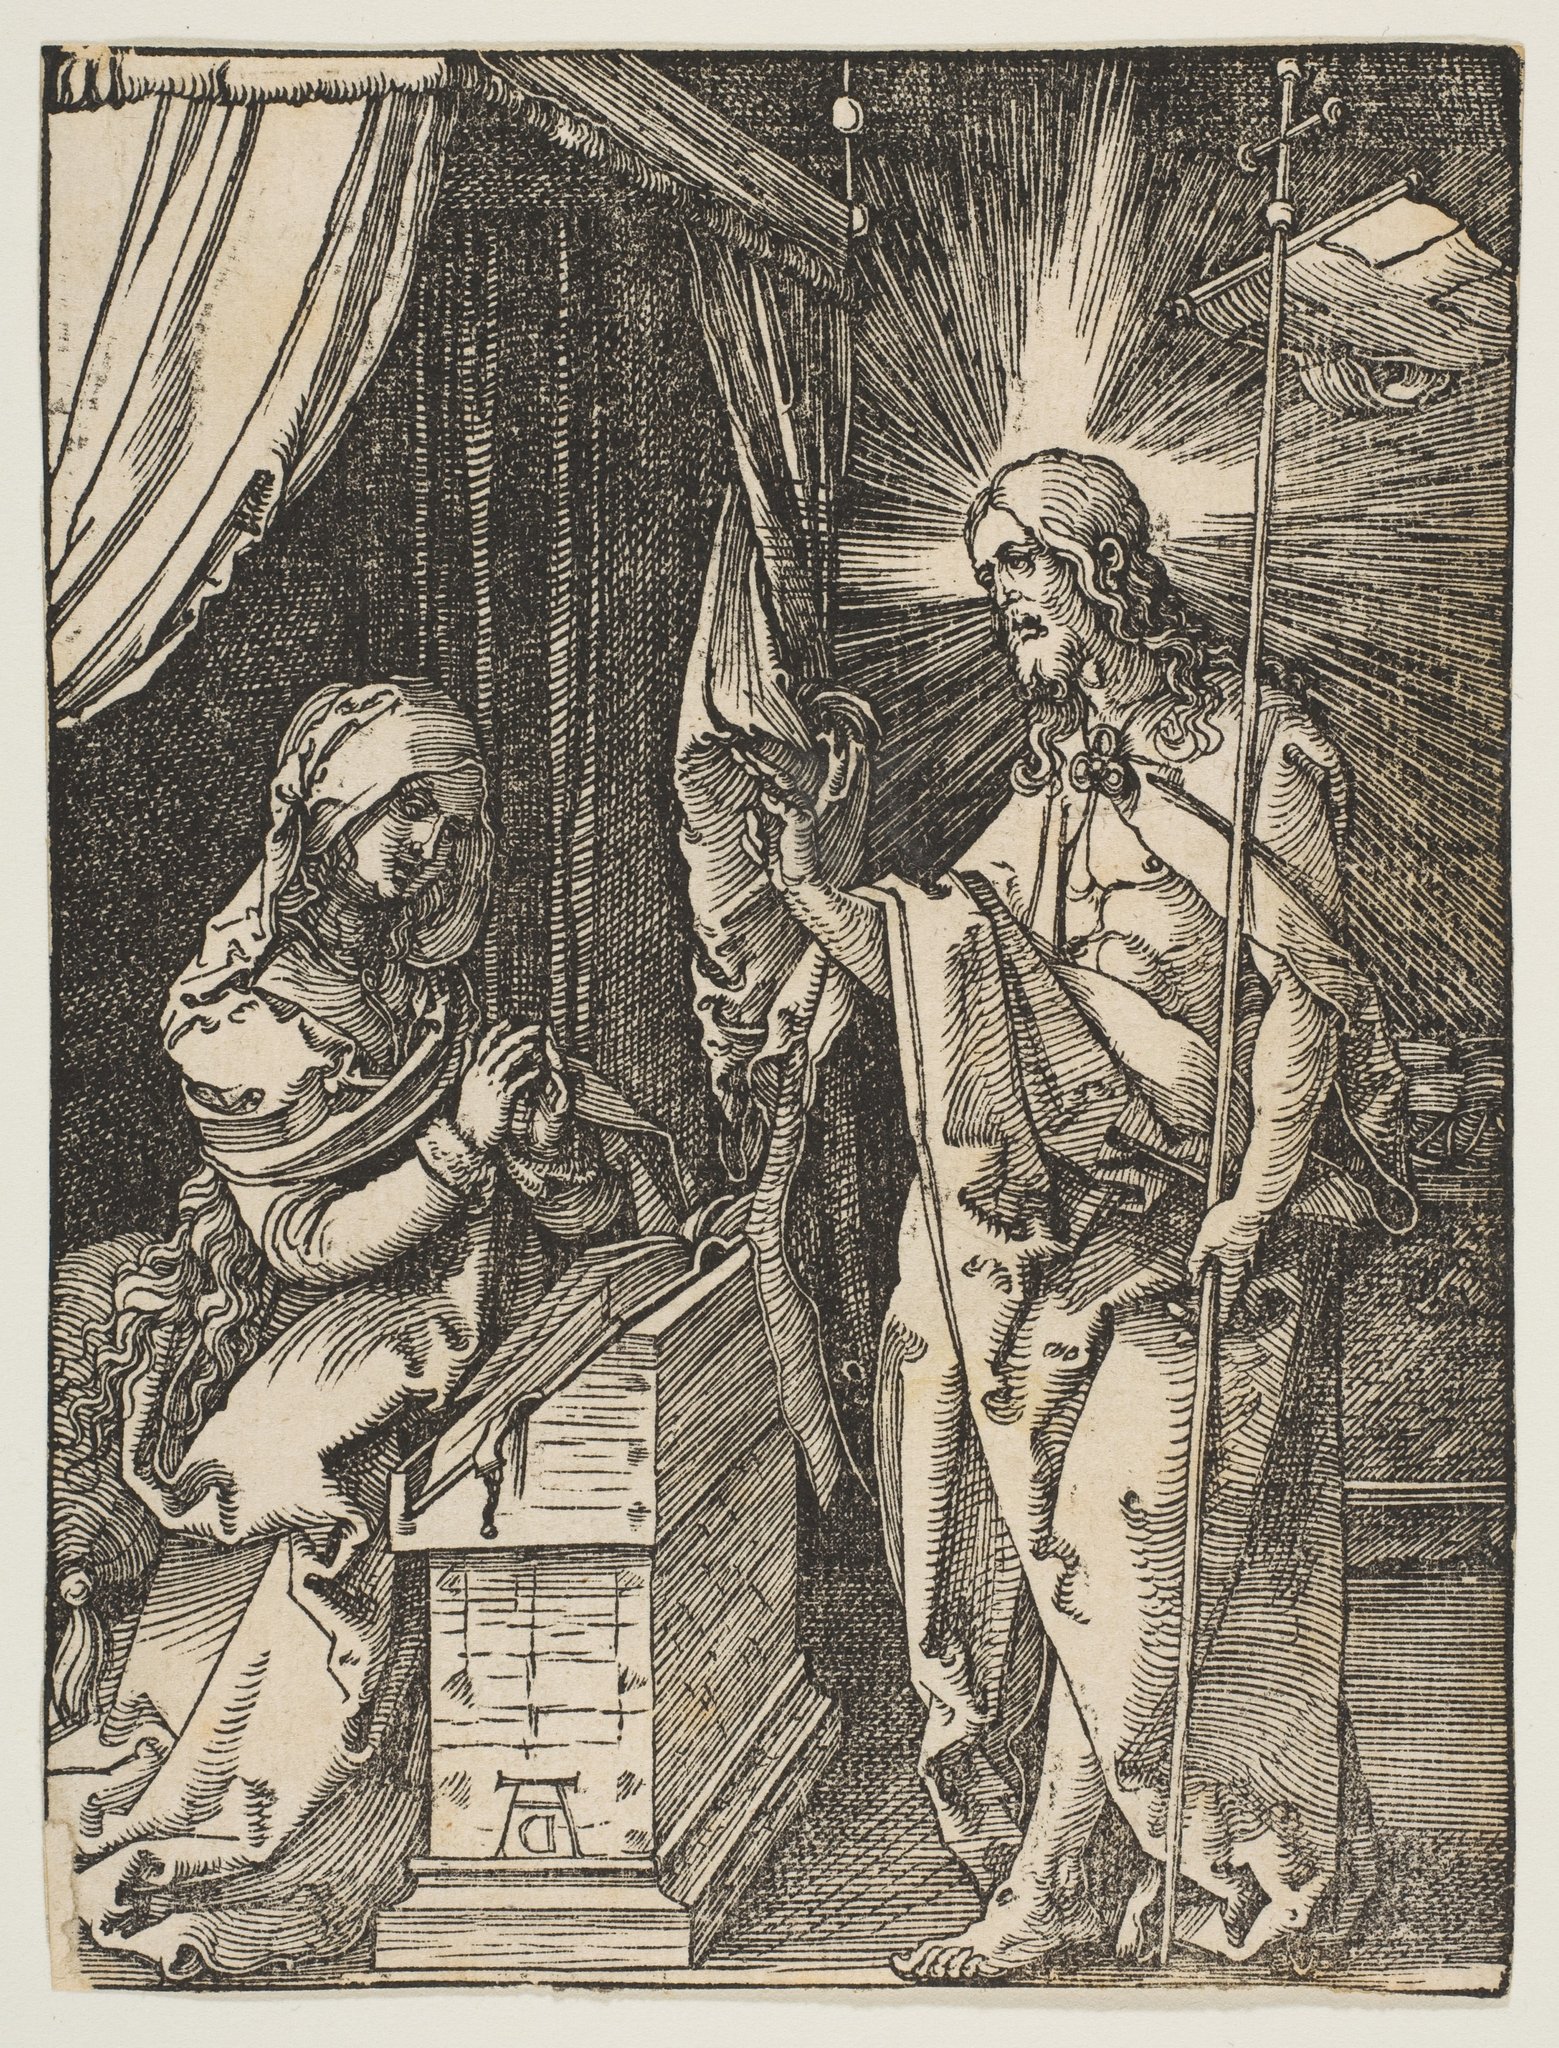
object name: print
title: Christ Appearing to His Mother, from "The Small Passion"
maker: albrecht dürer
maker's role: artist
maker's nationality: german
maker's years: 1471-1528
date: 1510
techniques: woodcut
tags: christ,virgin mary,cross